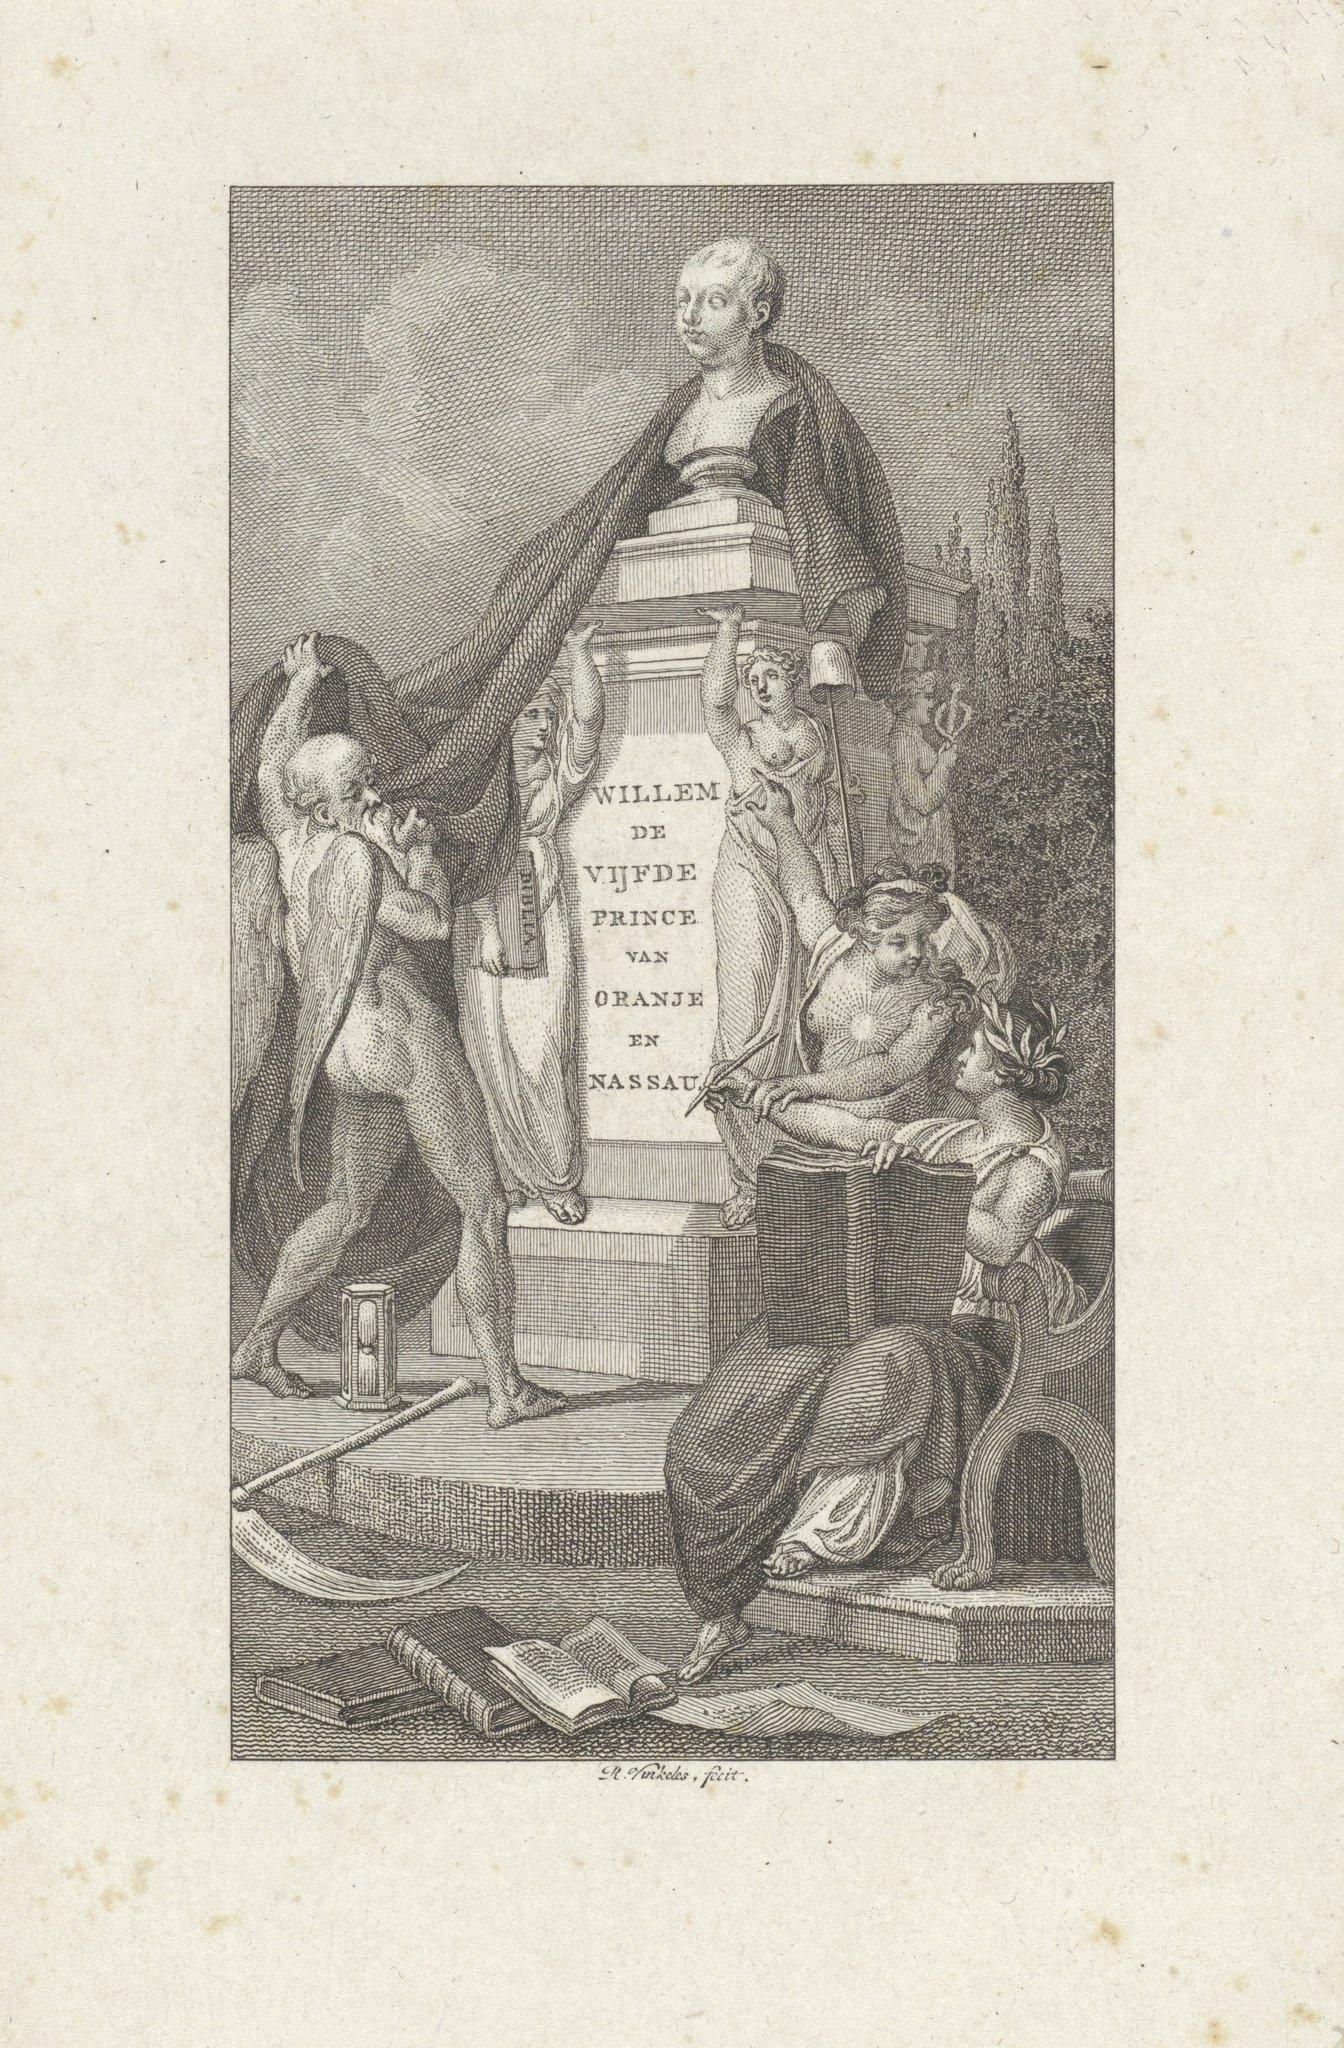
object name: print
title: Allegorische voorstelling op het graf van Willem V, prins van Oranje-Nassau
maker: reinier vinkeles (i)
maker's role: draughtsman, print maker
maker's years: 1741-1816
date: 1806-1808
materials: paper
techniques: engraving, etching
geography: amsterdam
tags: william v (prince of orange), truth; 'verità' (ripa) (+ abstract concept represented by female figure), monument, statue, 'historia'; 'historia' (ripa), father time, man with wings and scythe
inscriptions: collector's mark: Lugt 2228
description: Vader Tijd onthult een monument met de buste van Willem V, prins van Oranje-Nassau. De buste wordt gedragen door een allegorische vrouwenfiguur met een vrijheidshoed op stok en een vrouwenfiguur met een bijbel. Op de voorgrond wijst de vrouwelijke personificatie van de waarheid, de Geschiedschrijving met lauwerkrans en boek, op het beeld van Willem V.